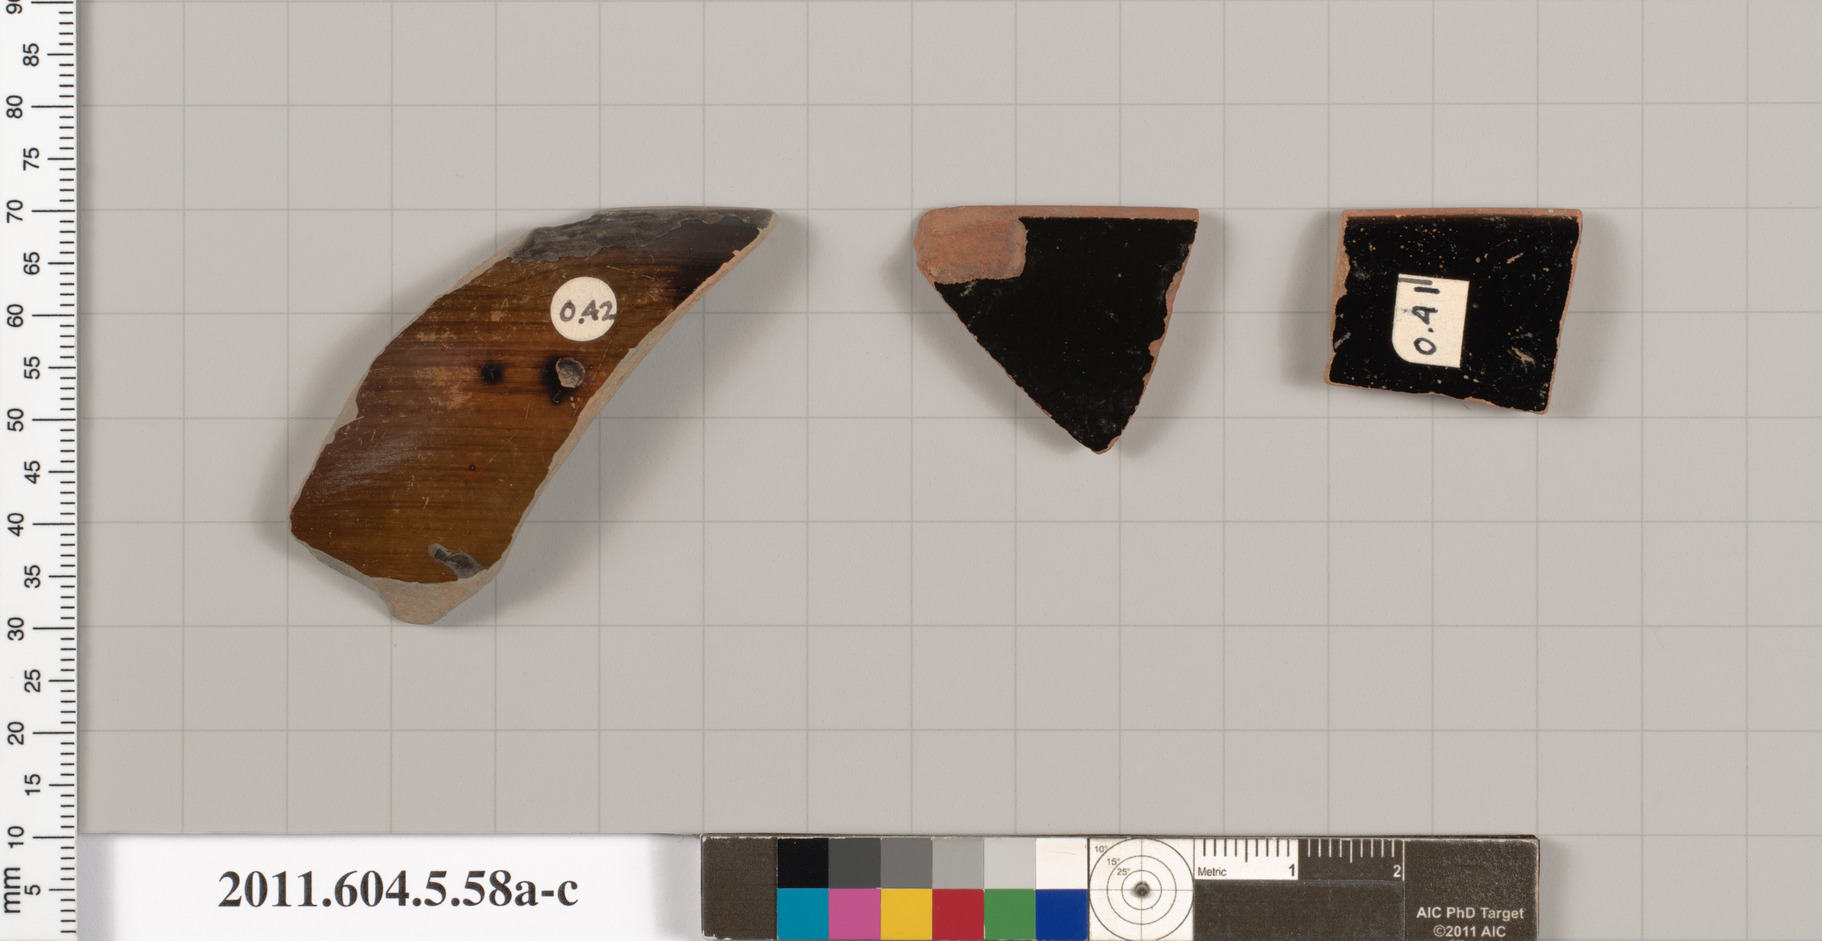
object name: kylix fragment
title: Terracotta rim fragments of kylikes (drinking cups)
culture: greek, attic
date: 500-401 BCE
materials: terracotta